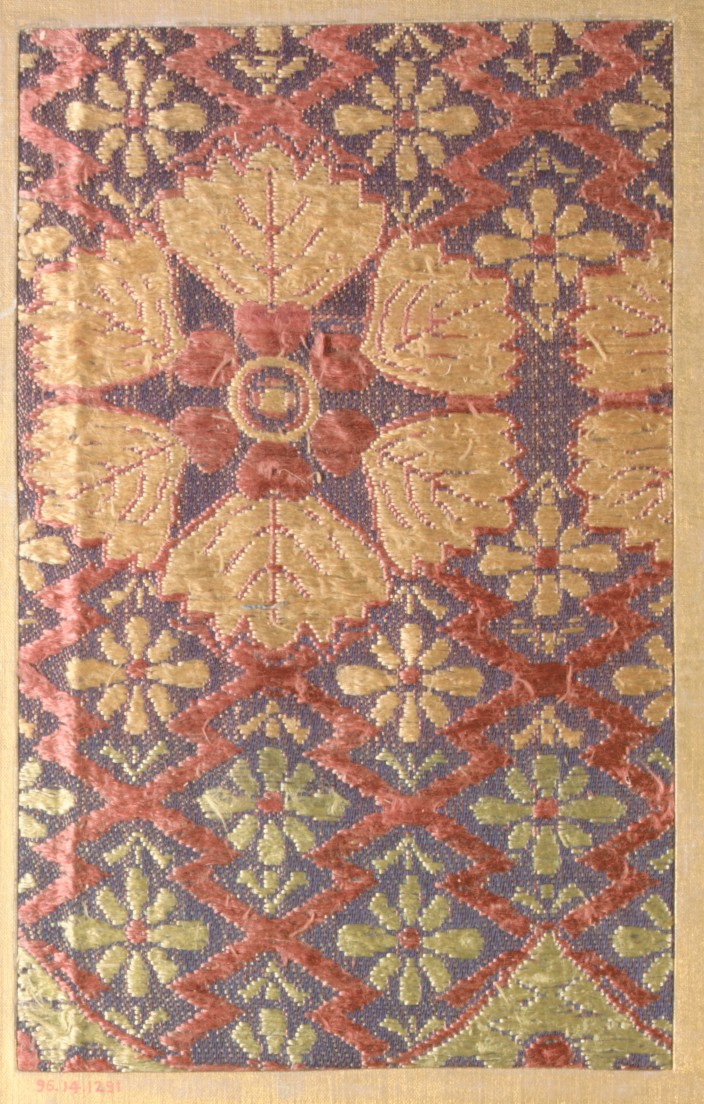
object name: piece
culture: japanese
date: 1701-1900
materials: silk